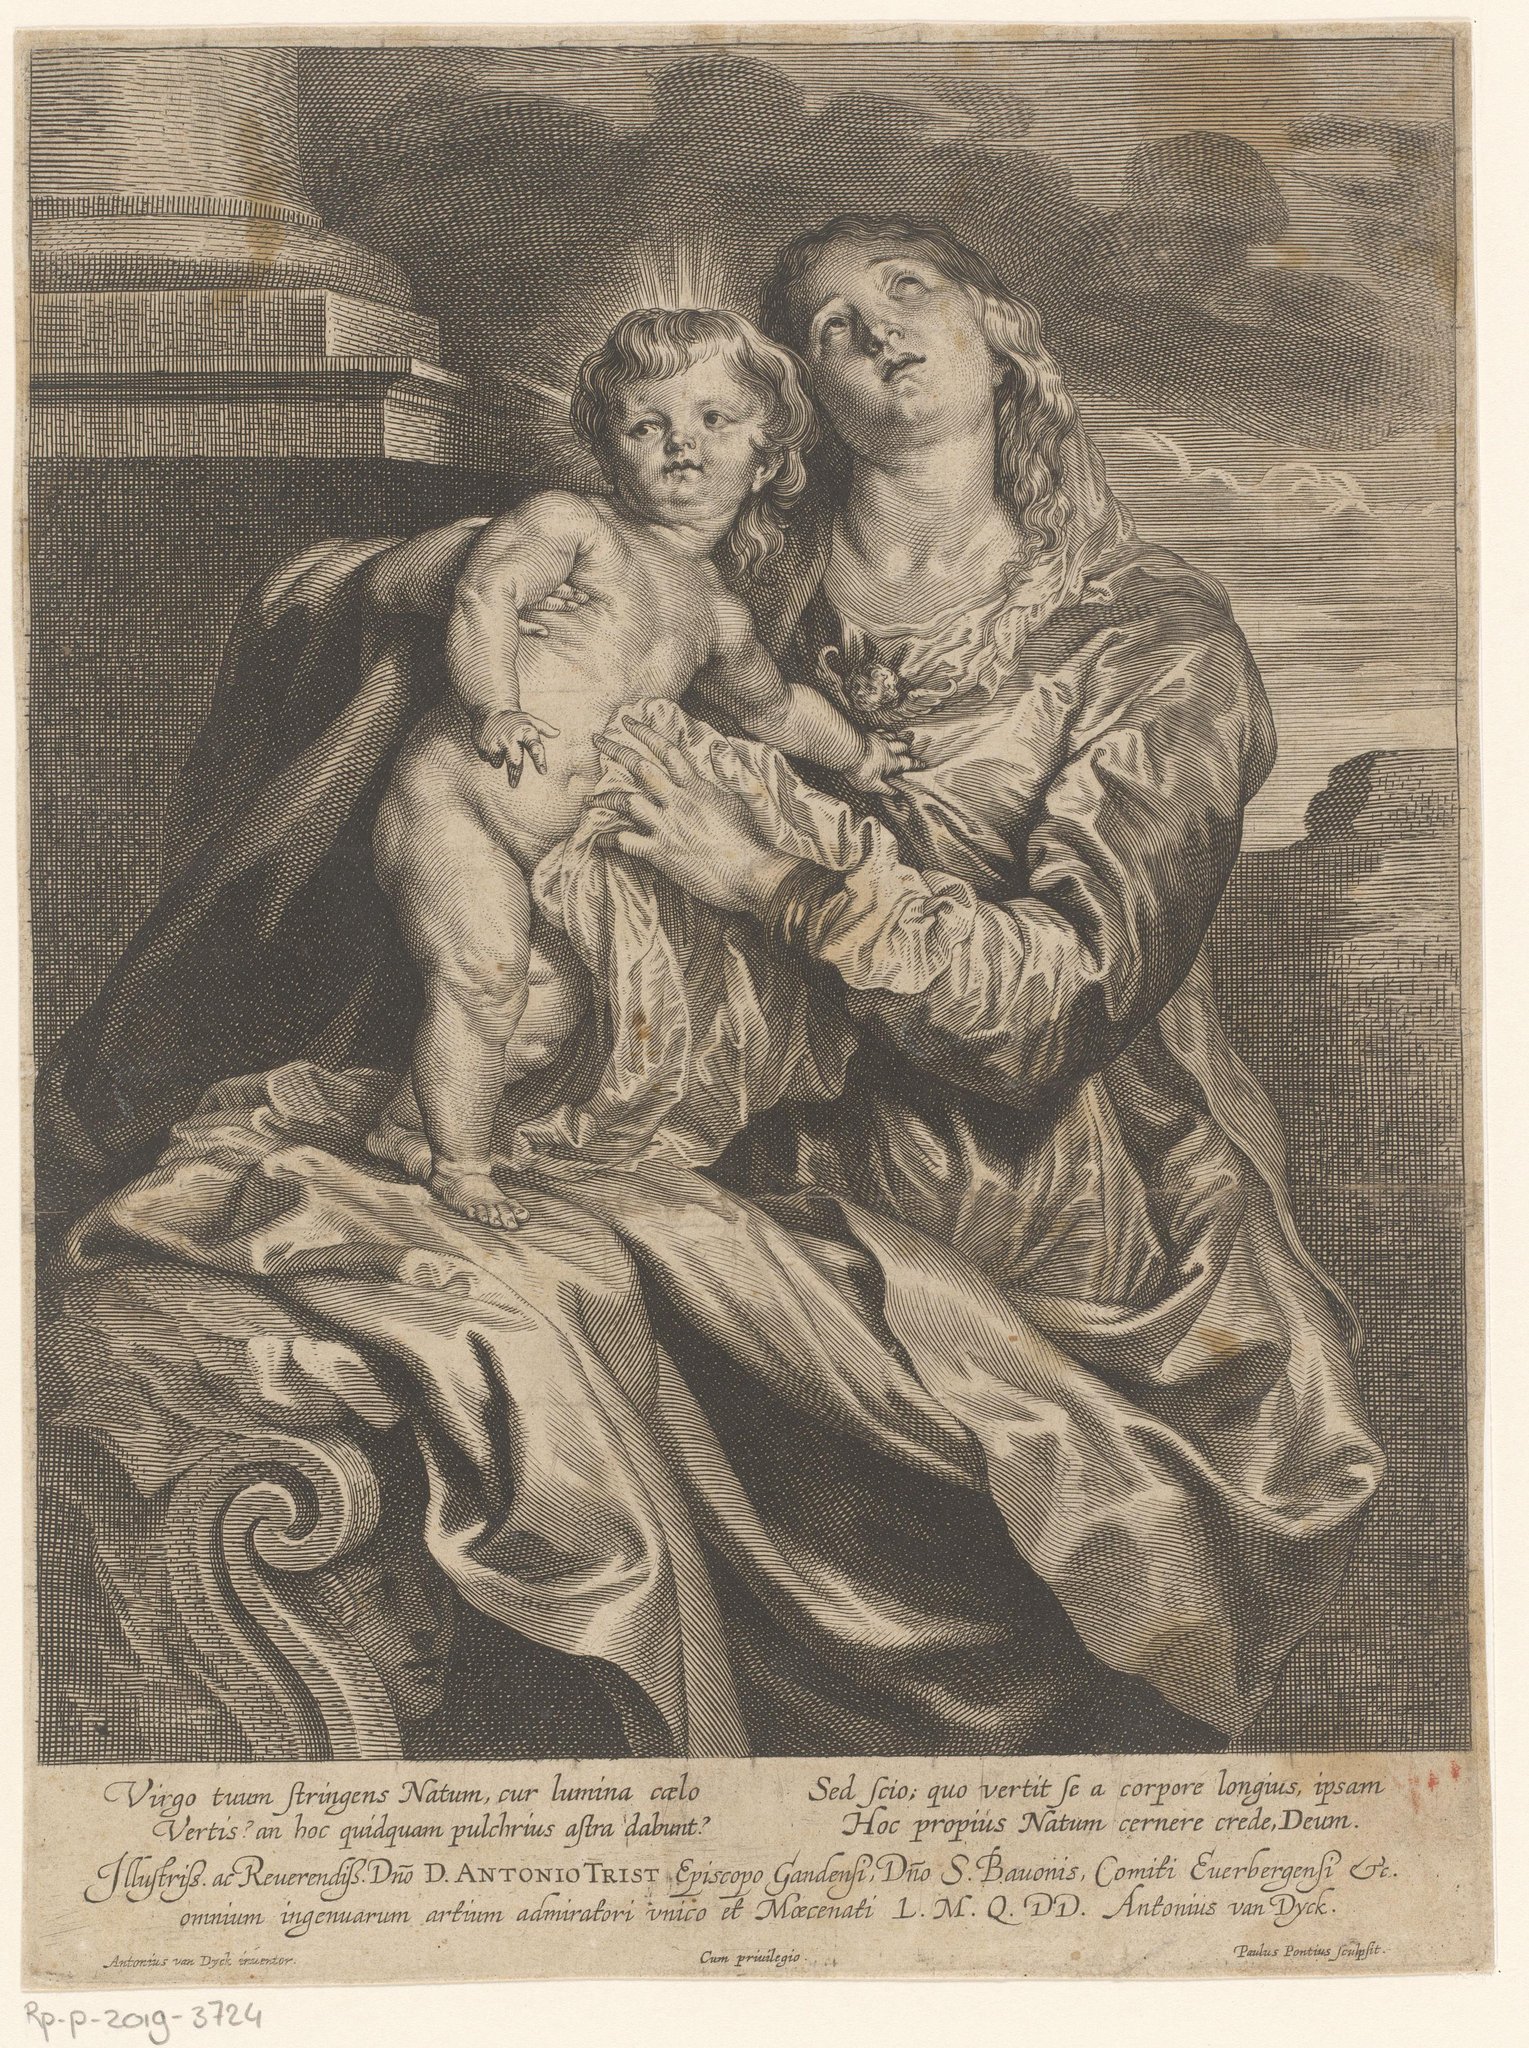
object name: print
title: Maria met het Christuskind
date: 1613-1657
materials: paper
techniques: engraving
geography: antwerp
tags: mary sitting or enthroned, the christ-child standing on her knee (christ-child to mary's left) - ff - the christ-child to mary's right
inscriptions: collector's mark: Lugt 2228, collector's mark: Lugt 2028